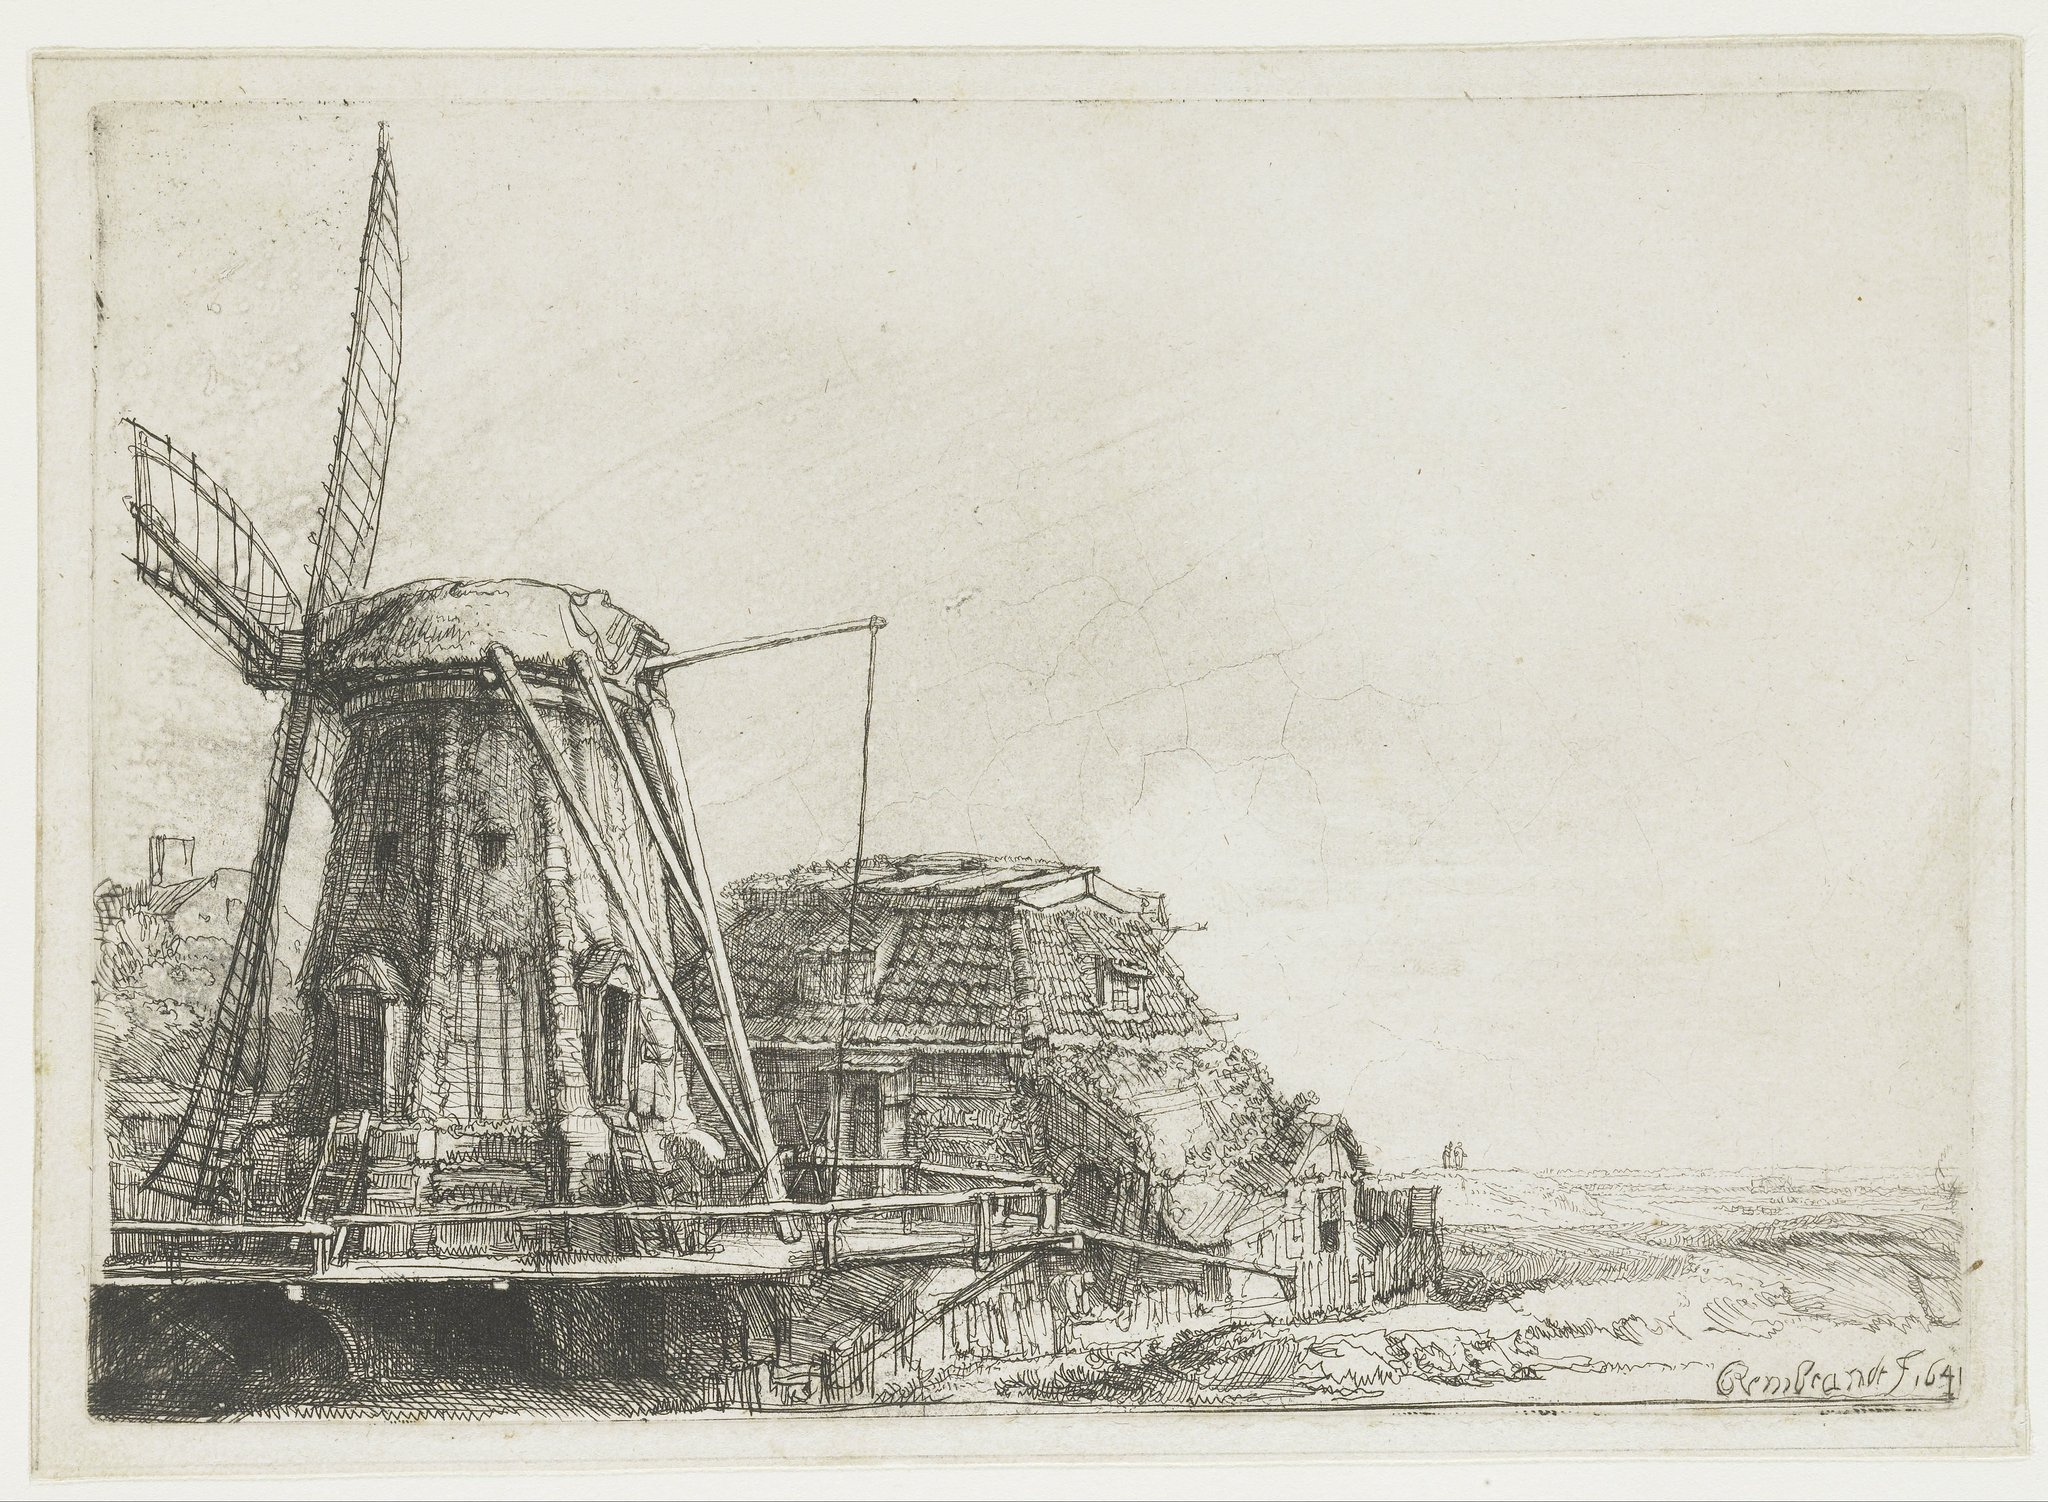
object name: print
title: The windmill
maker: rembrandt van rijn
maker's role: draughtsman, painter, print maker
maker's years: 1606-1669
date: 1641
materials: paper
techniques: etching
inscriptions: signature and date: ‘Rembrandt f 1641’, collector's mark: Lugt 240